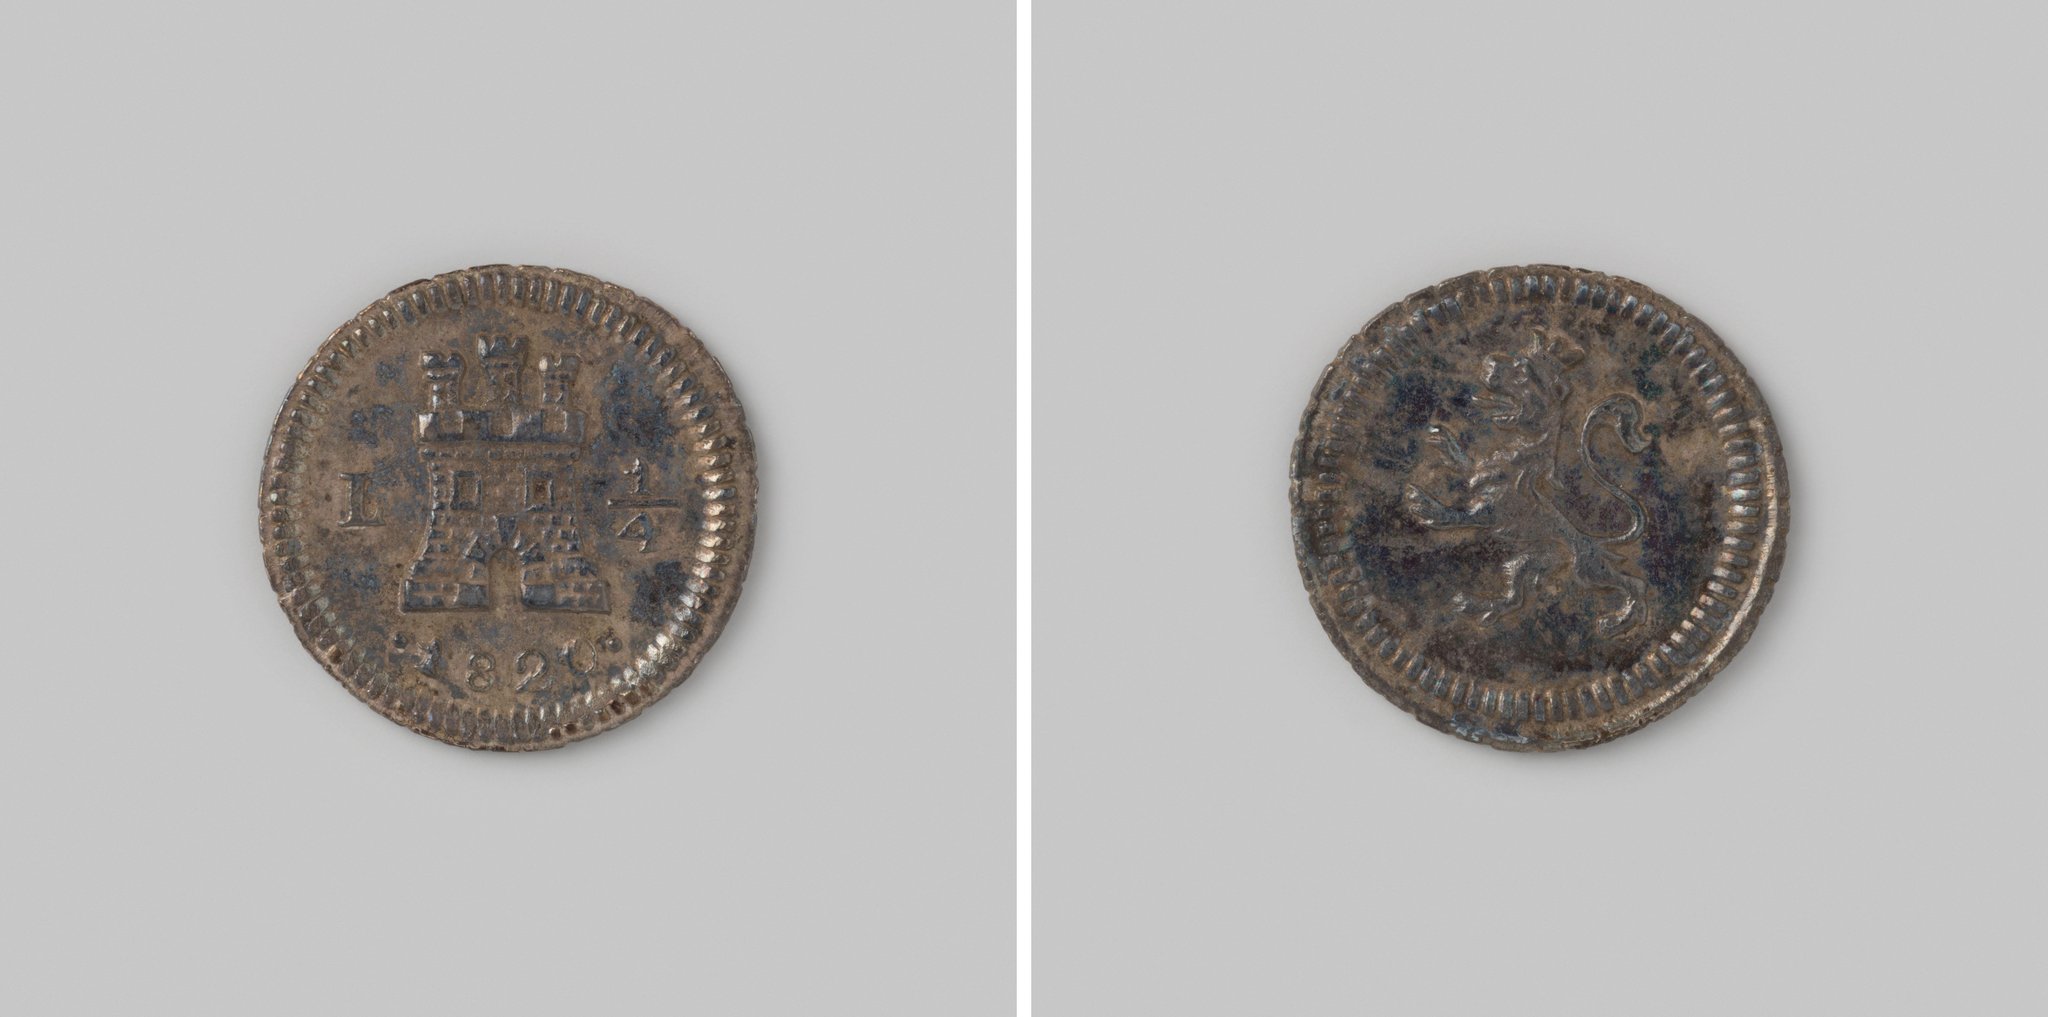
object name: coin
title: Kwart reaal uit Peru van koning Ferdinand VII,1820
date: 1820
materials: silver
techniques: striking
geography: lima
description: Zilveren munt. Voorzijde: tussen muntplaats-aanduiding: L [=Lima] en waarde-aanduiding: 1/4, kasteel. Jaartal onderaan. Keerzijde: gekroonde klimmende leeuw naar links. Gladde rand.